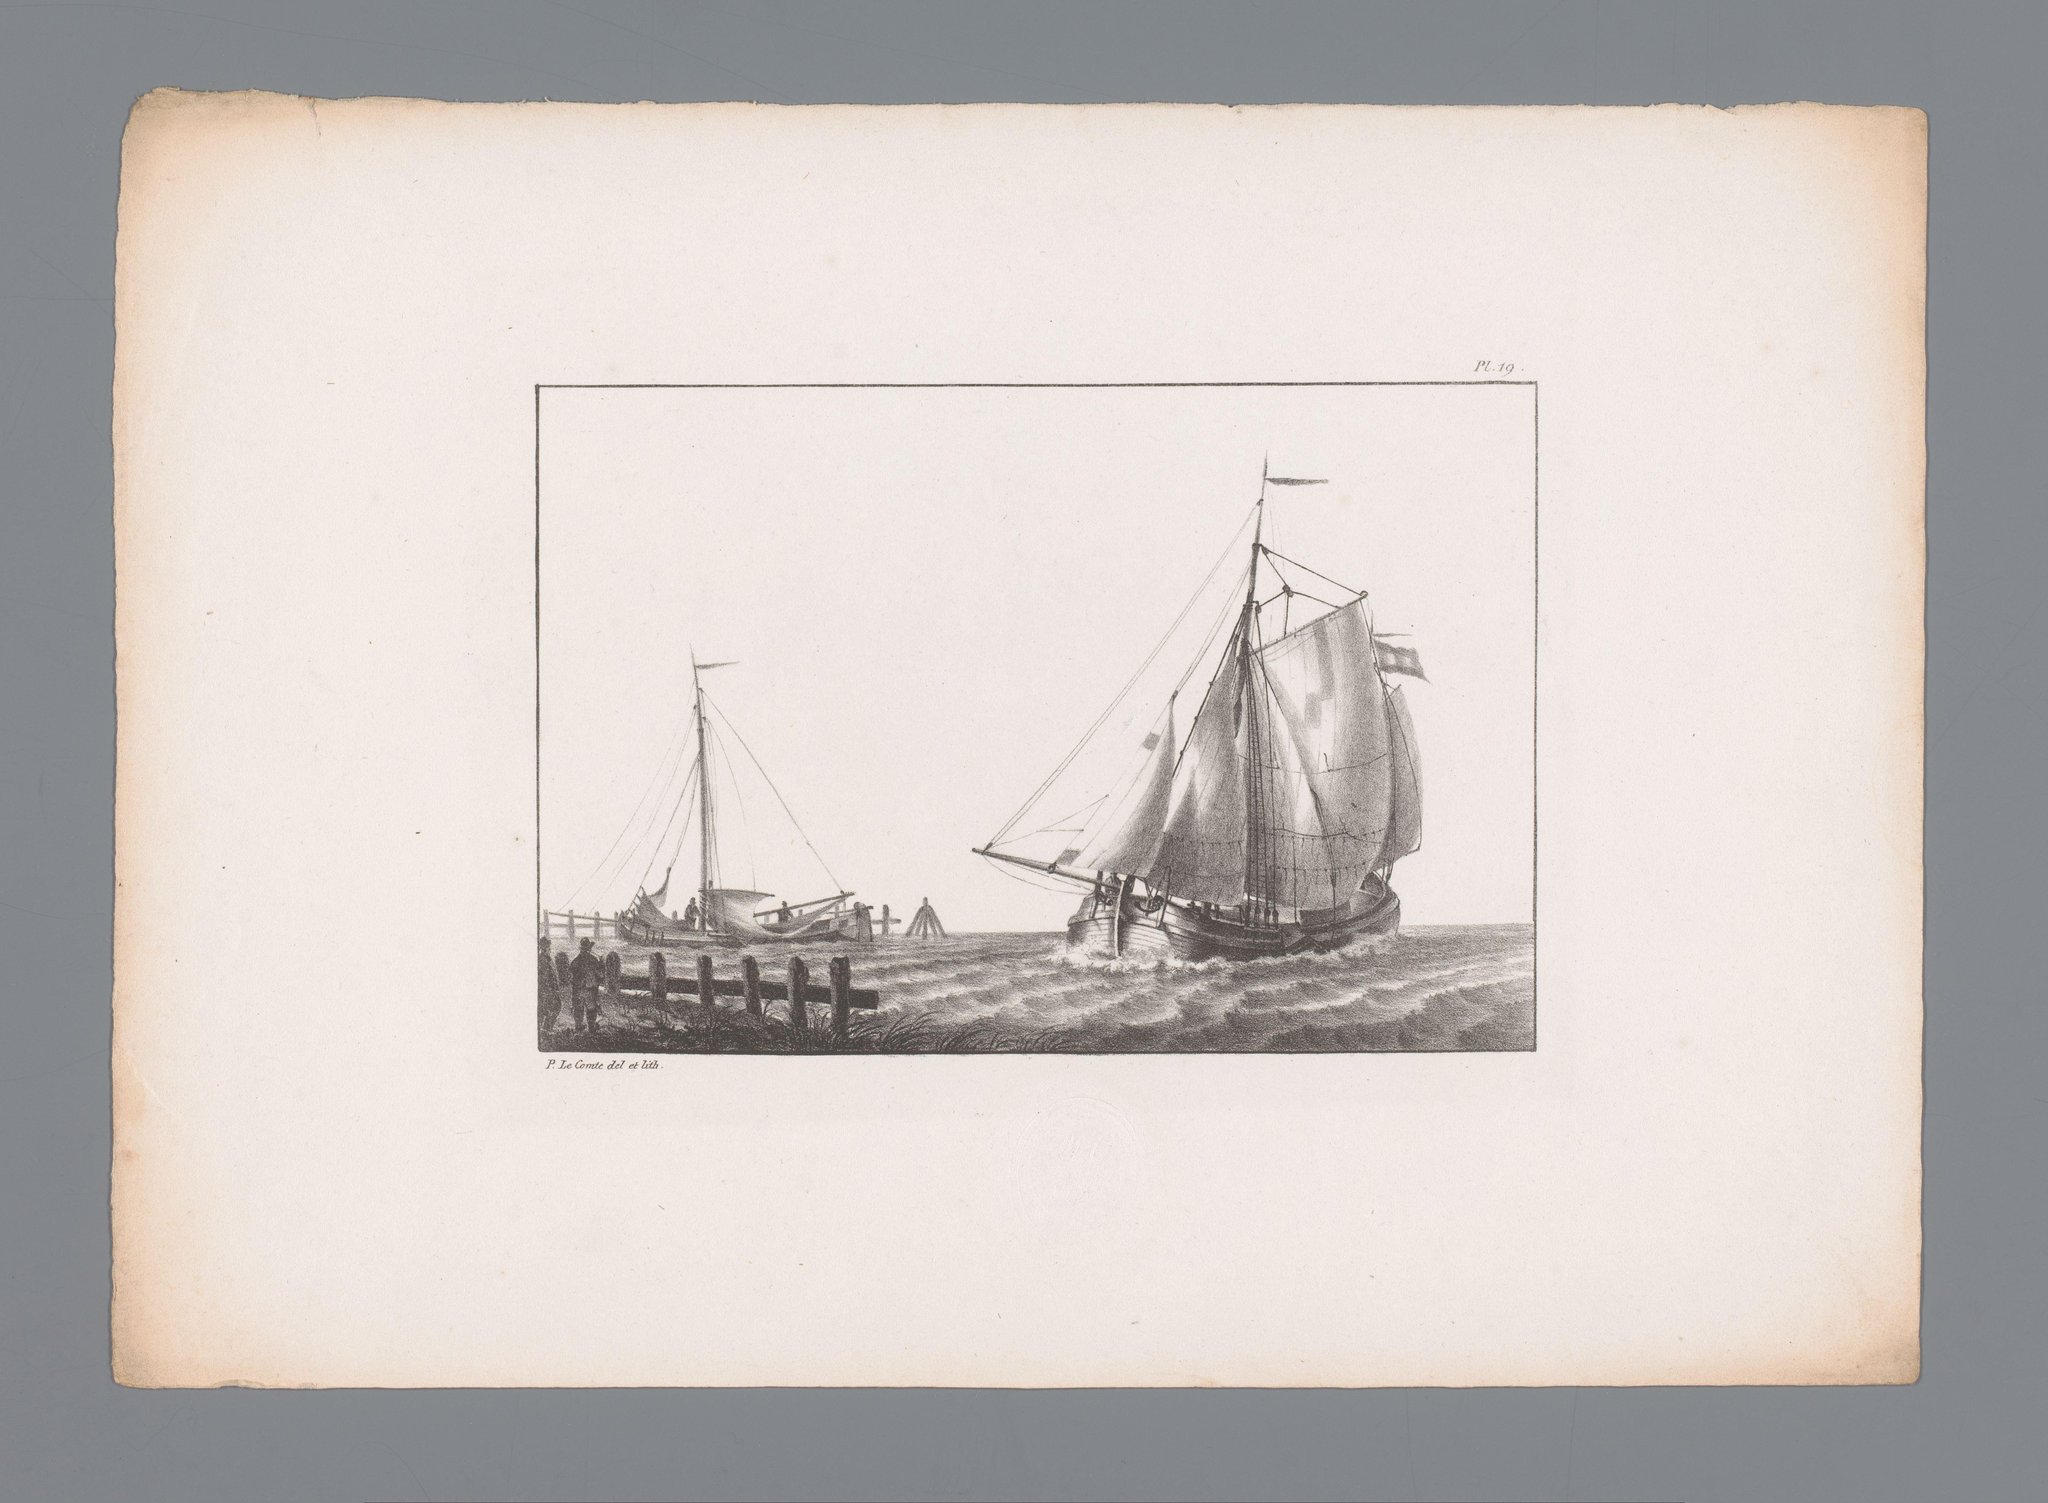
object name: print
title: Brabants beurtschip of gaffelaar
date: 1831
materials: paper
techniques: lithograph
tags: sailing-ship, sailing-boat, ships (in general)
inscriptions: collector's mark: ‘PLC RMWO’, collector's mark: Lugt 2228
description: Genummerd rechtsboven: Pl. 19. Deze prent maakt deel uit van een omslag met negentien prenten.